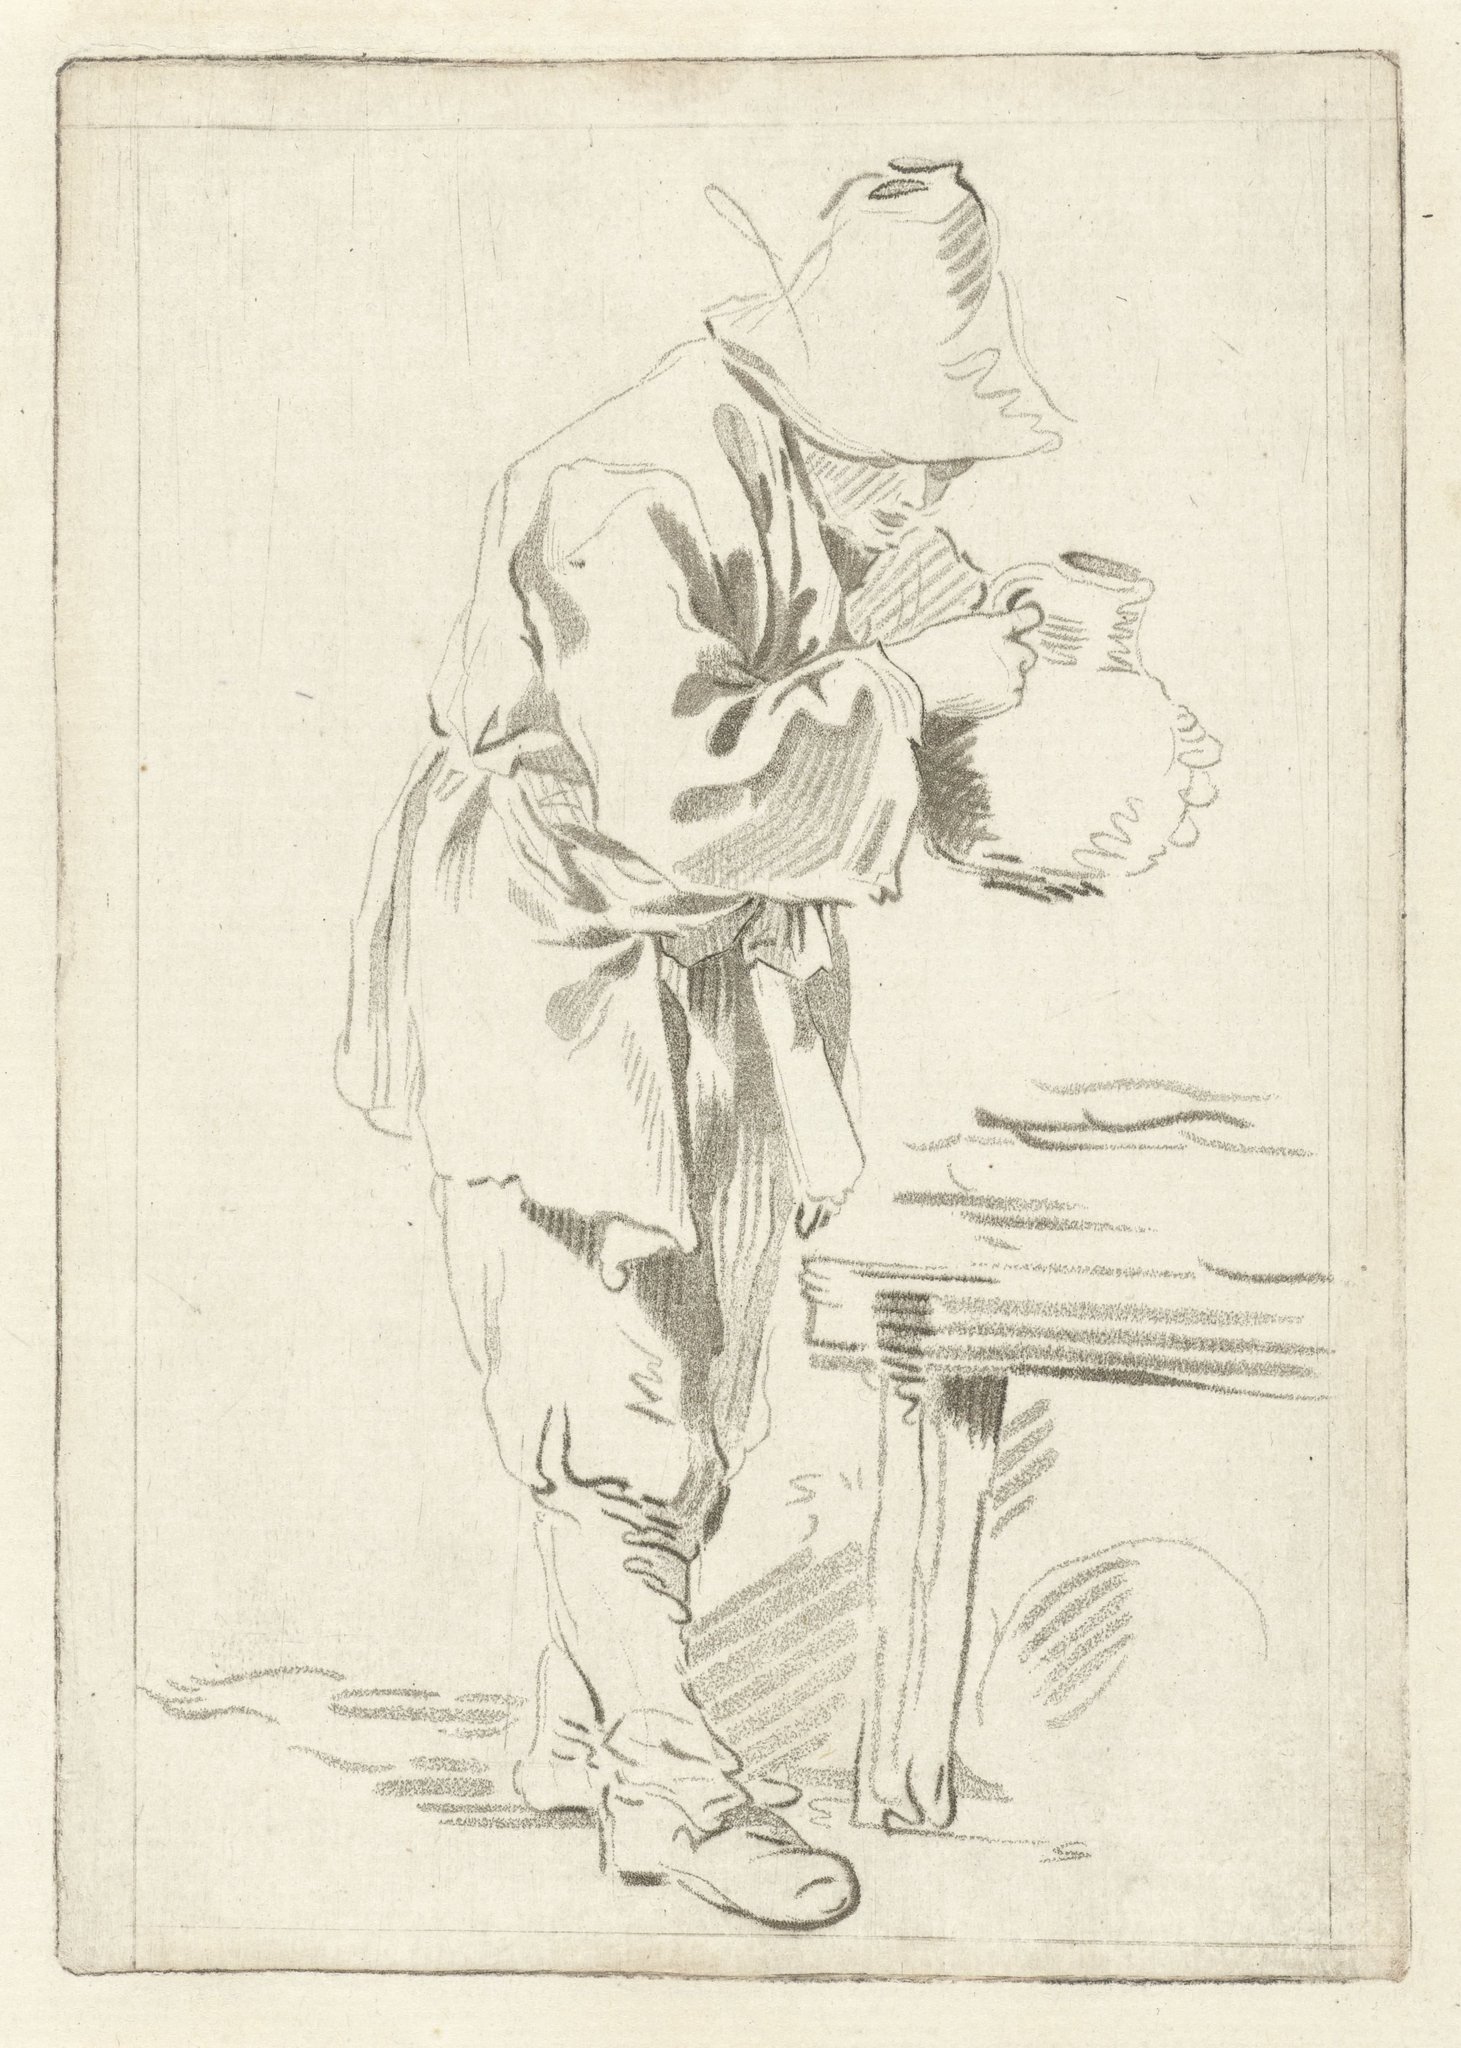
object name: print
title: Staande man met kruik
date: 1767-1780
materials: paper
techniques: printmaking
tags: jar, jug (used as drinking-vessel)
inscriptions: collector's mark: Lugt 240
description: Een man met een hoed op het hoofd en een kruik in de handen, staande bij een tafel.